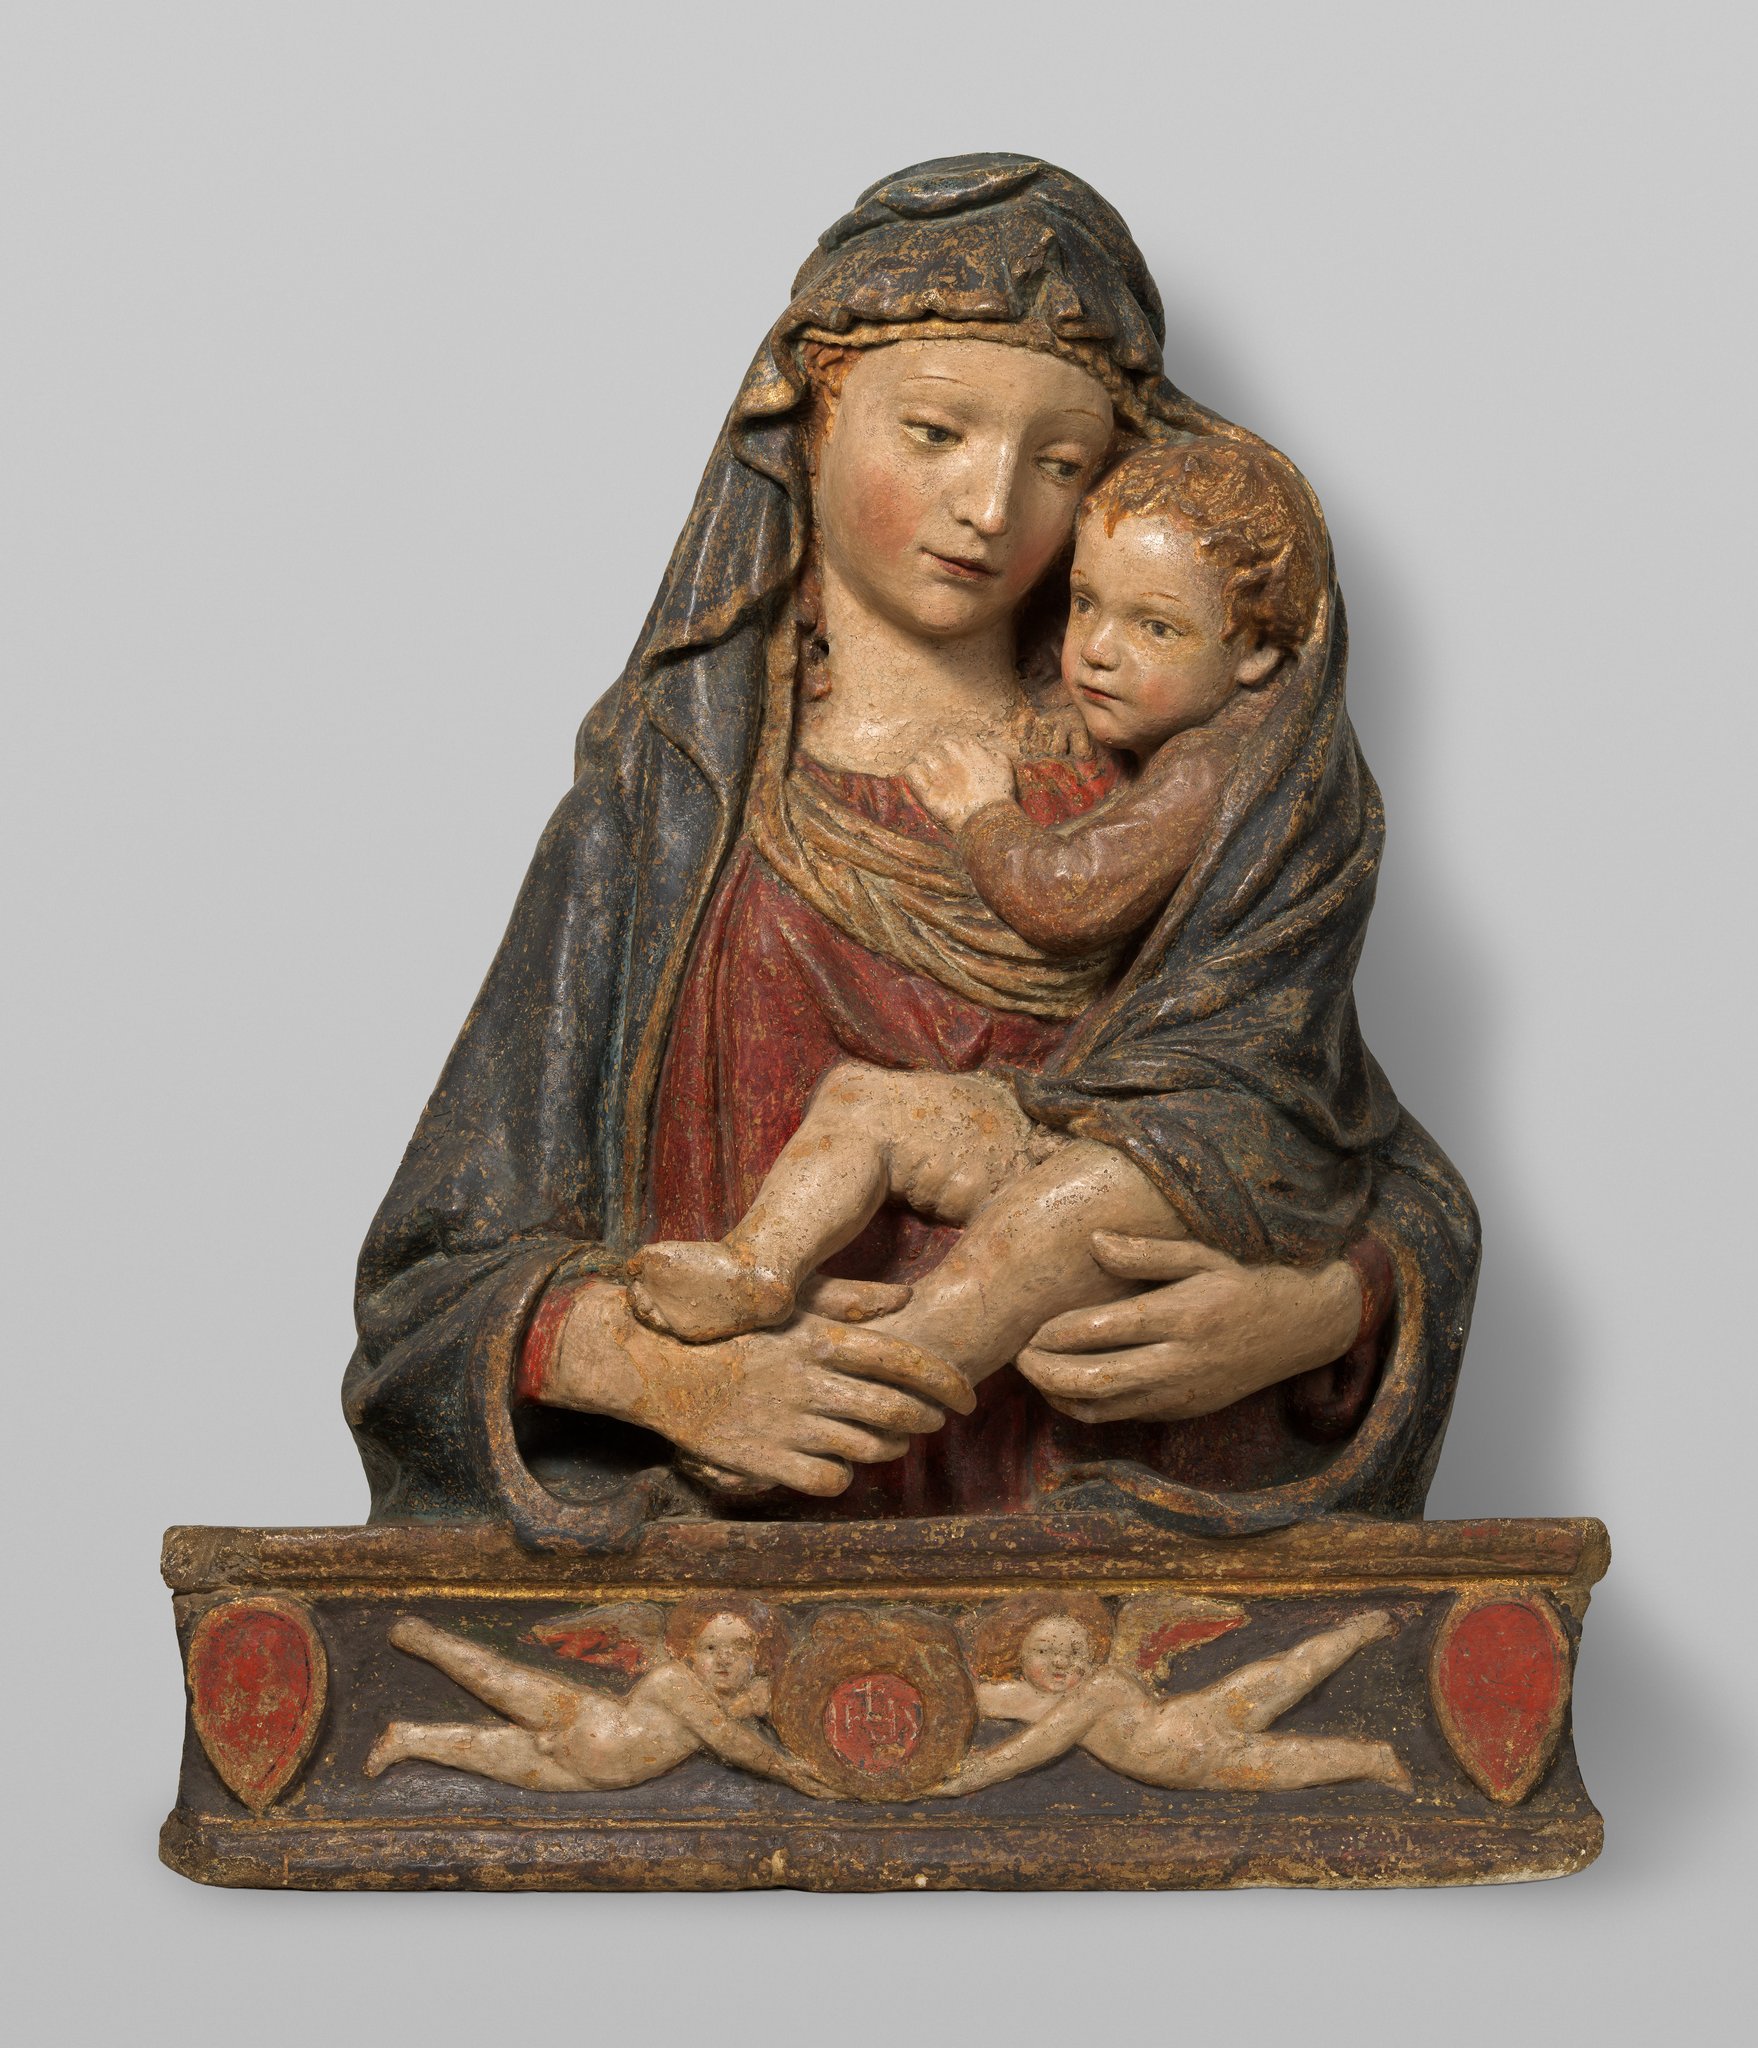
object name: high relief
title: Madonna and Child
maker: lorenzo ghiberti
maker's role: artist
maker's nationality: italian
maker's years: 1378-1455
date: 1425-1440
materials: plaster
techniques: polychrome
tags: madonna and child